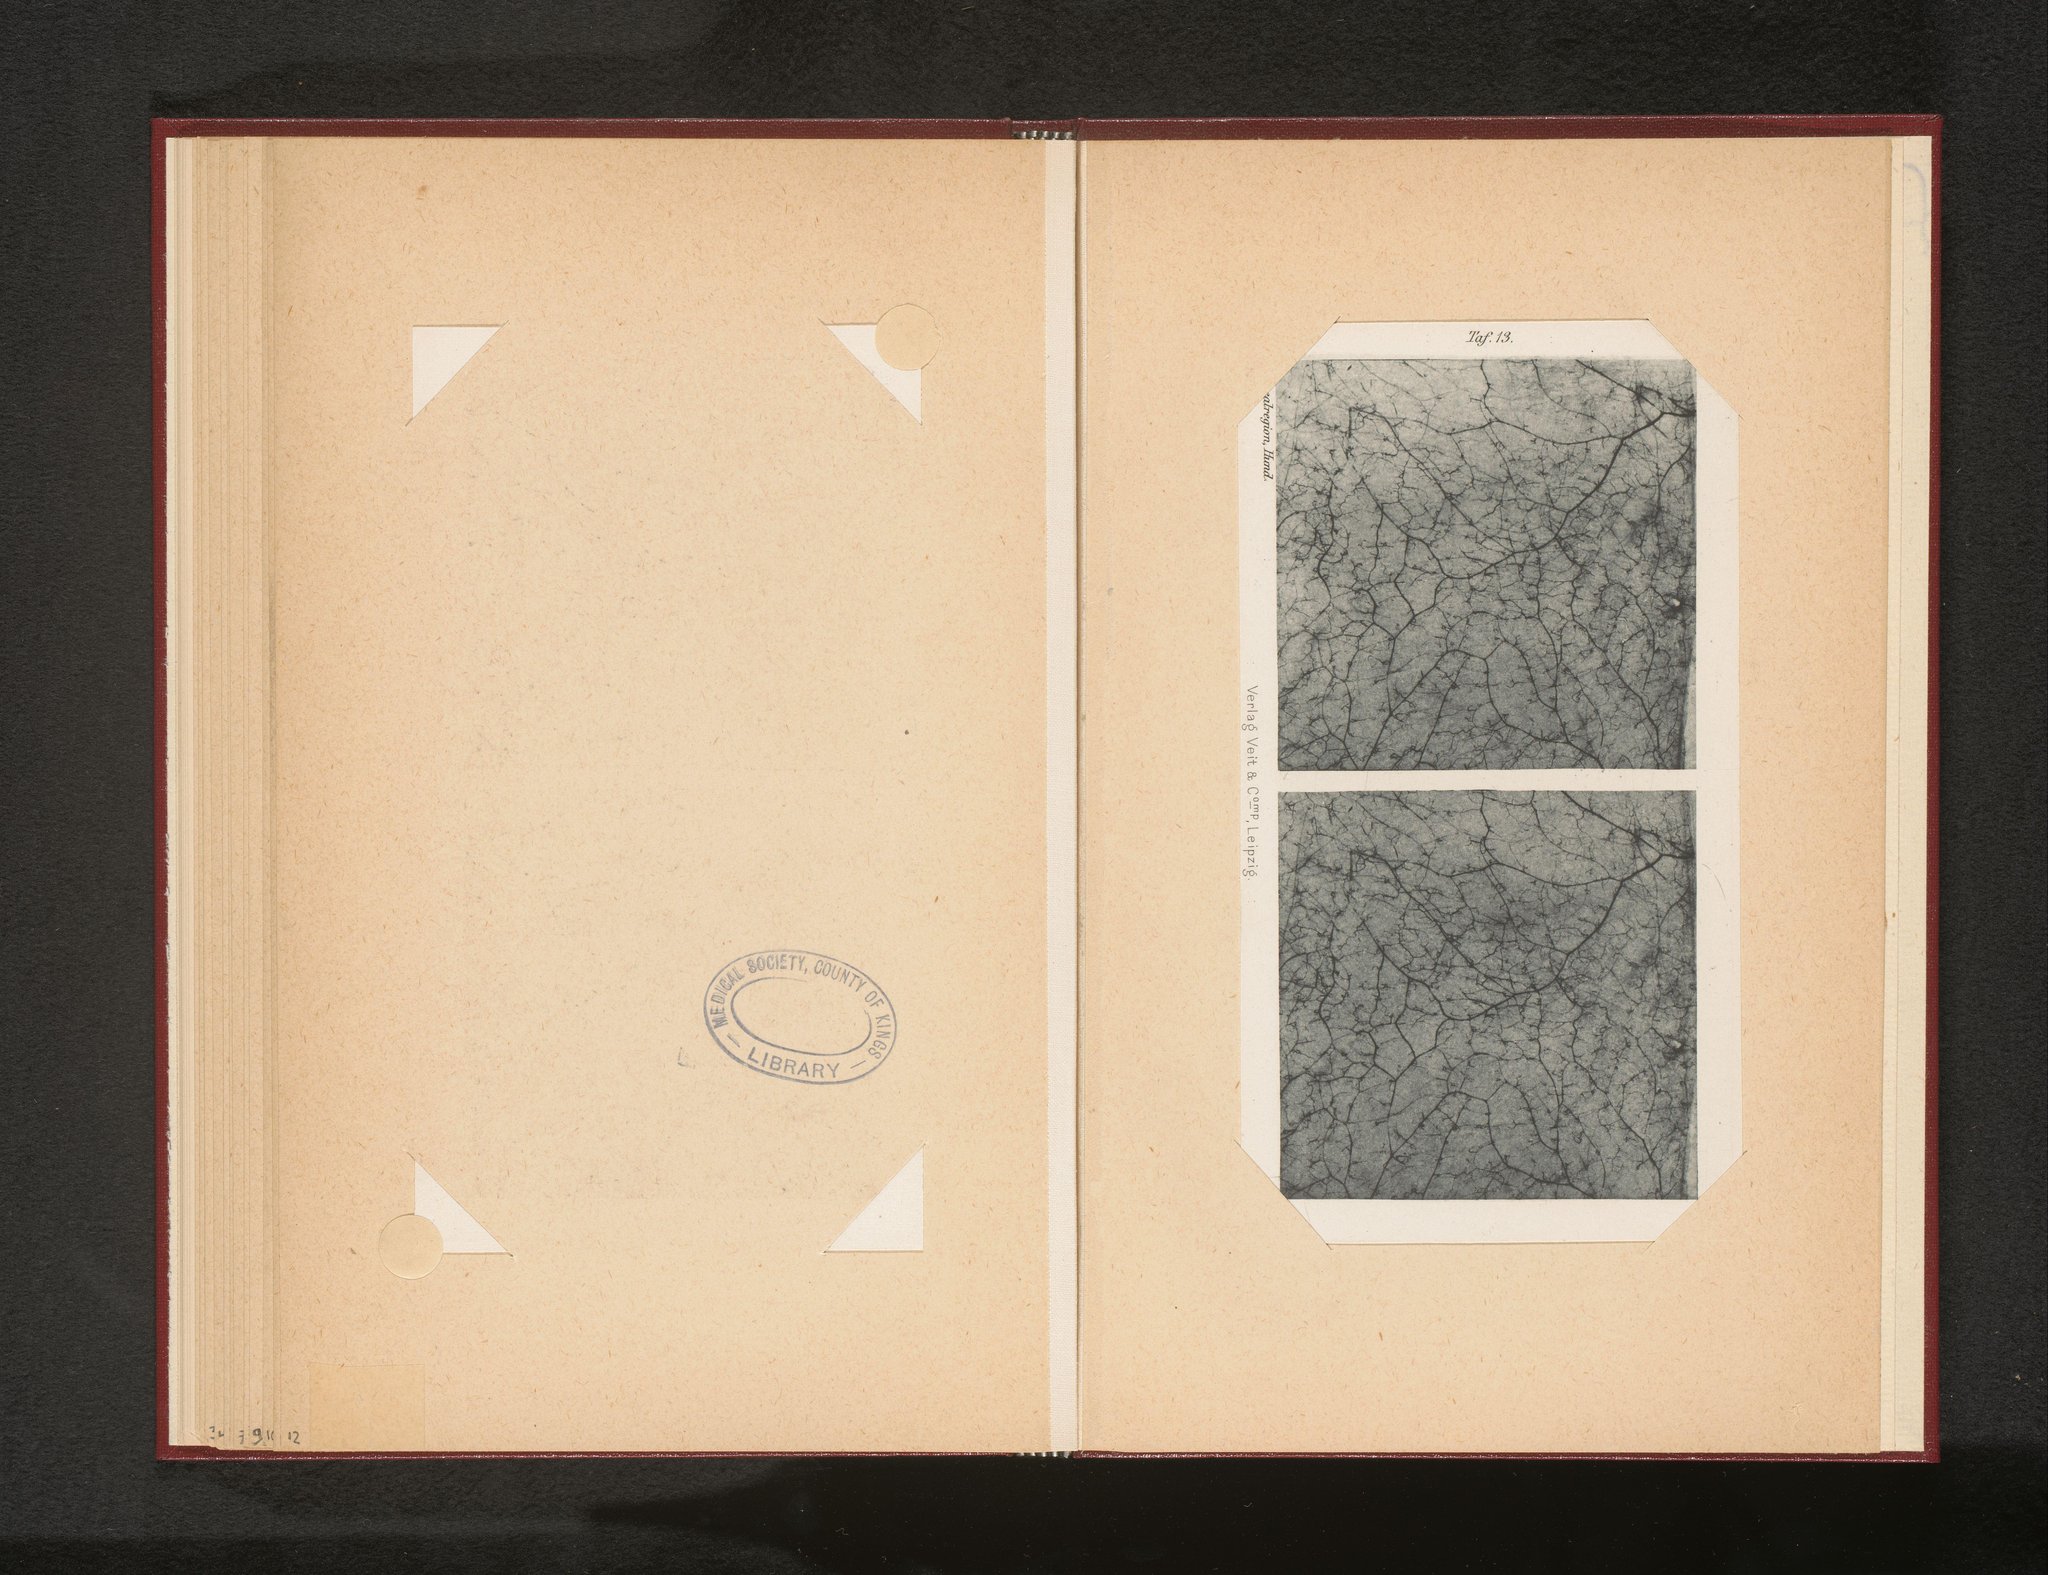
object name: photomechanical print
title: Microscoopopname van huid van de billen van een hond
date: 1885-1895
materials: paper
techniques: photoaquatint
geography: leipzig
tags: skin (human)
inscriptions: number: ‘Taf. 13.’